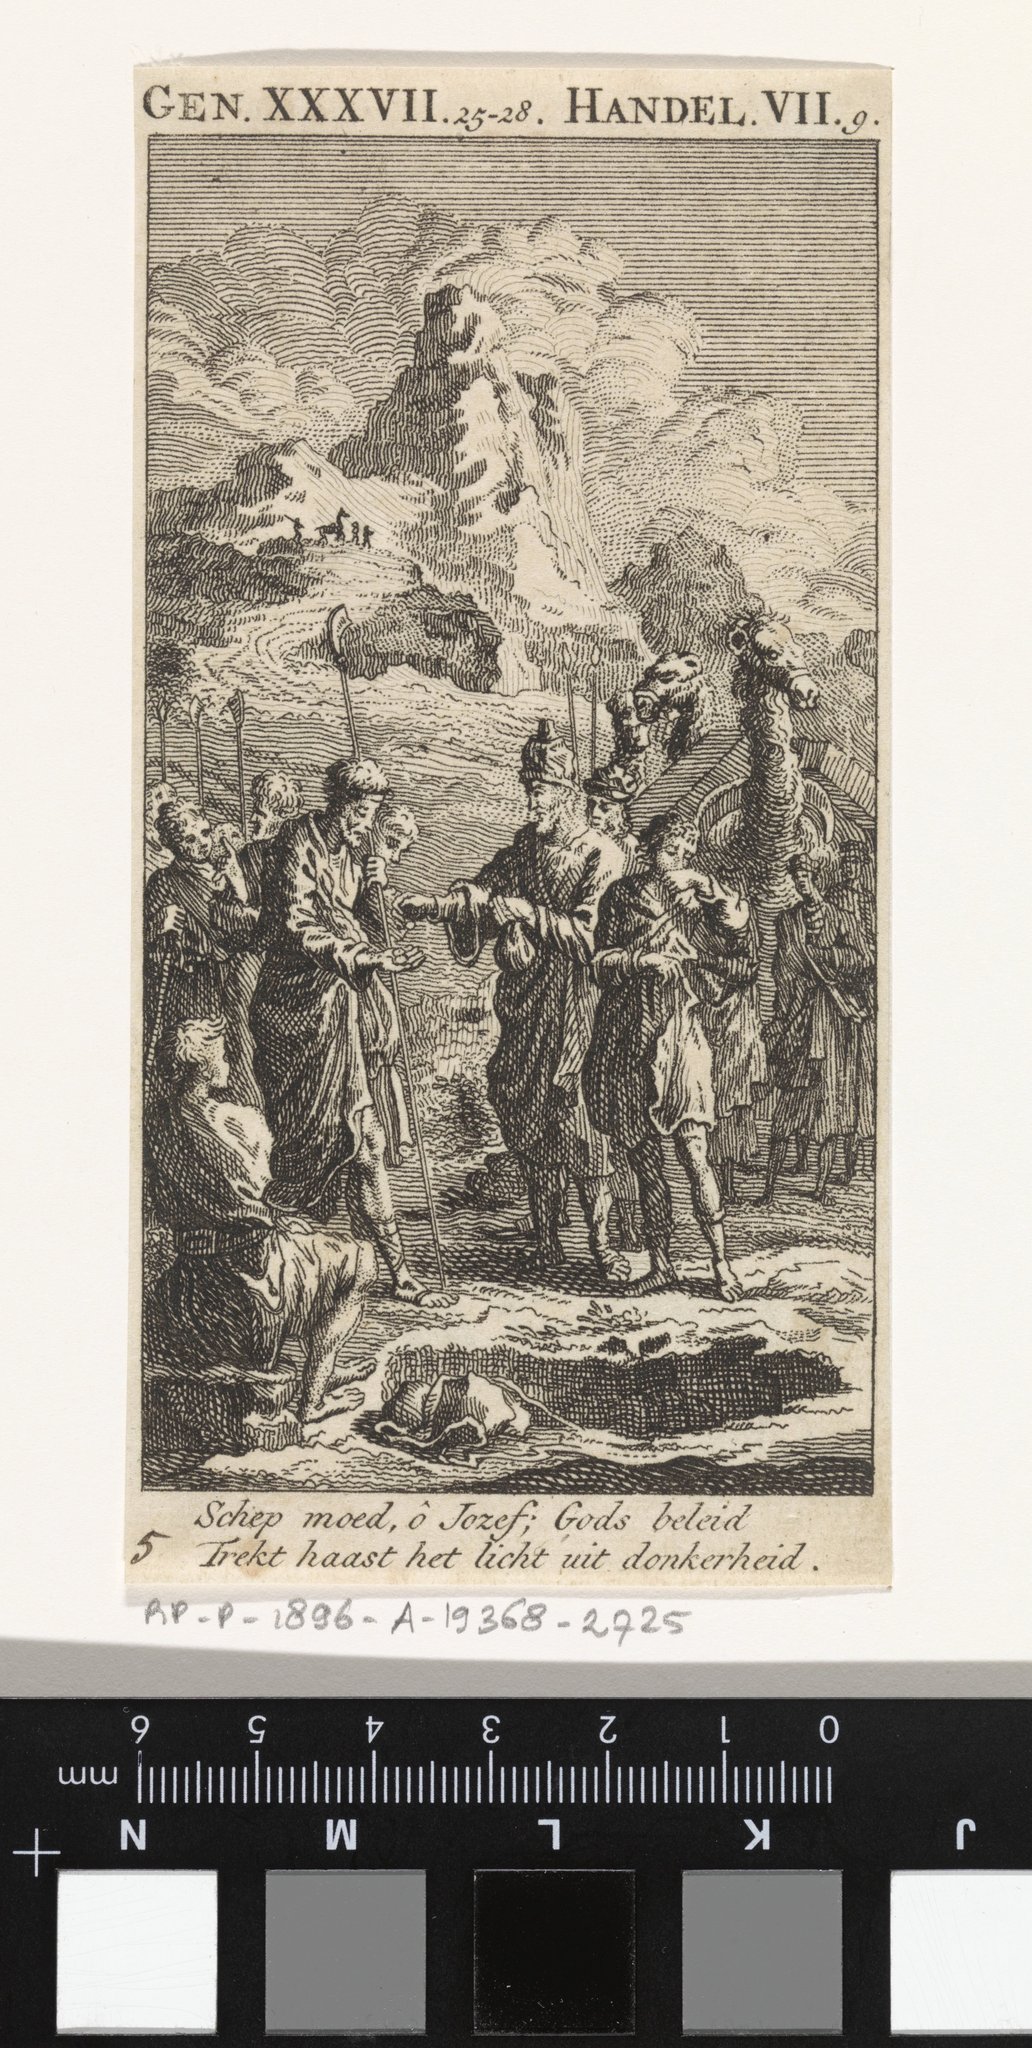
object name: print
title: Jozef wordt door zijn broers verkocht aan kooplieden bij de put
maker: jan luyken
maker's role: draughtsman, print maker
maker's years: 1649-1712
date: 1712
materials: paper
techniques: etching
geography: amsterdam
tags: while joseph's brothers are eating, a caravan of ishmaelite (midianite) merchants passes by: judah proposes to sell joseph to them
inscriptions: collector's mark: Lugt 2228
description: Illustratie voor: Luyken, Jan. Bybel printen. Amsterdam: Pieter Arentsz. II (wed.) en Cornelis van der Sys, 1712, p. 5.